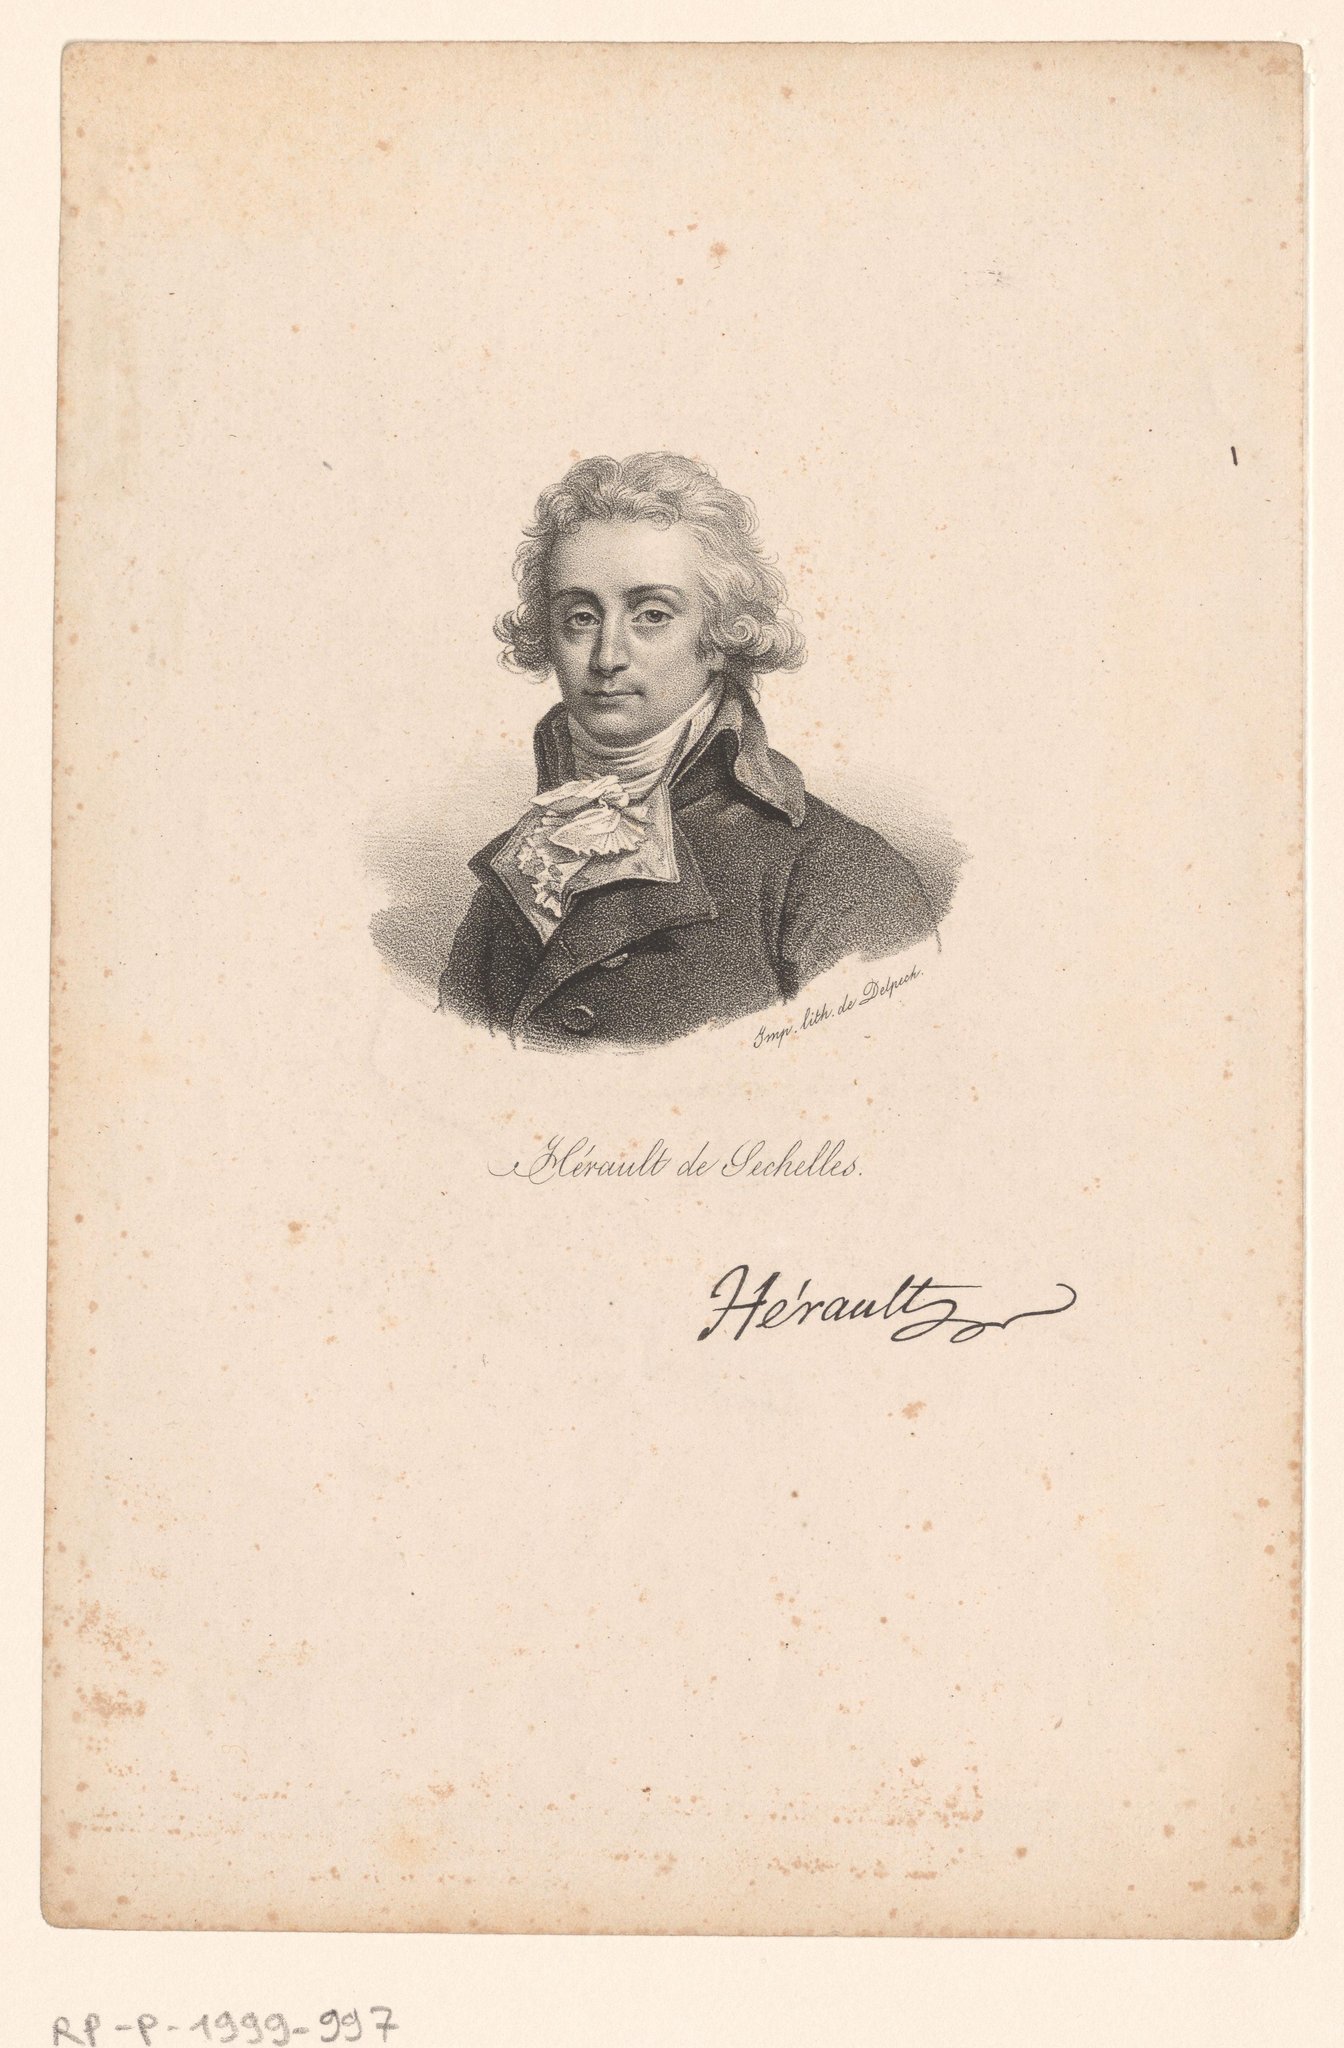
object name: print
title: Portret van Marie-Jean Hérault de Séchelles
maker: Anonymous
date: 1818-1842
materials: paper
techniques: lithograph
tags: historical persons, politician, e.g. party leader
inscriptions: collector's mark: Lugt 2760, collector's mark: Lugt 2228